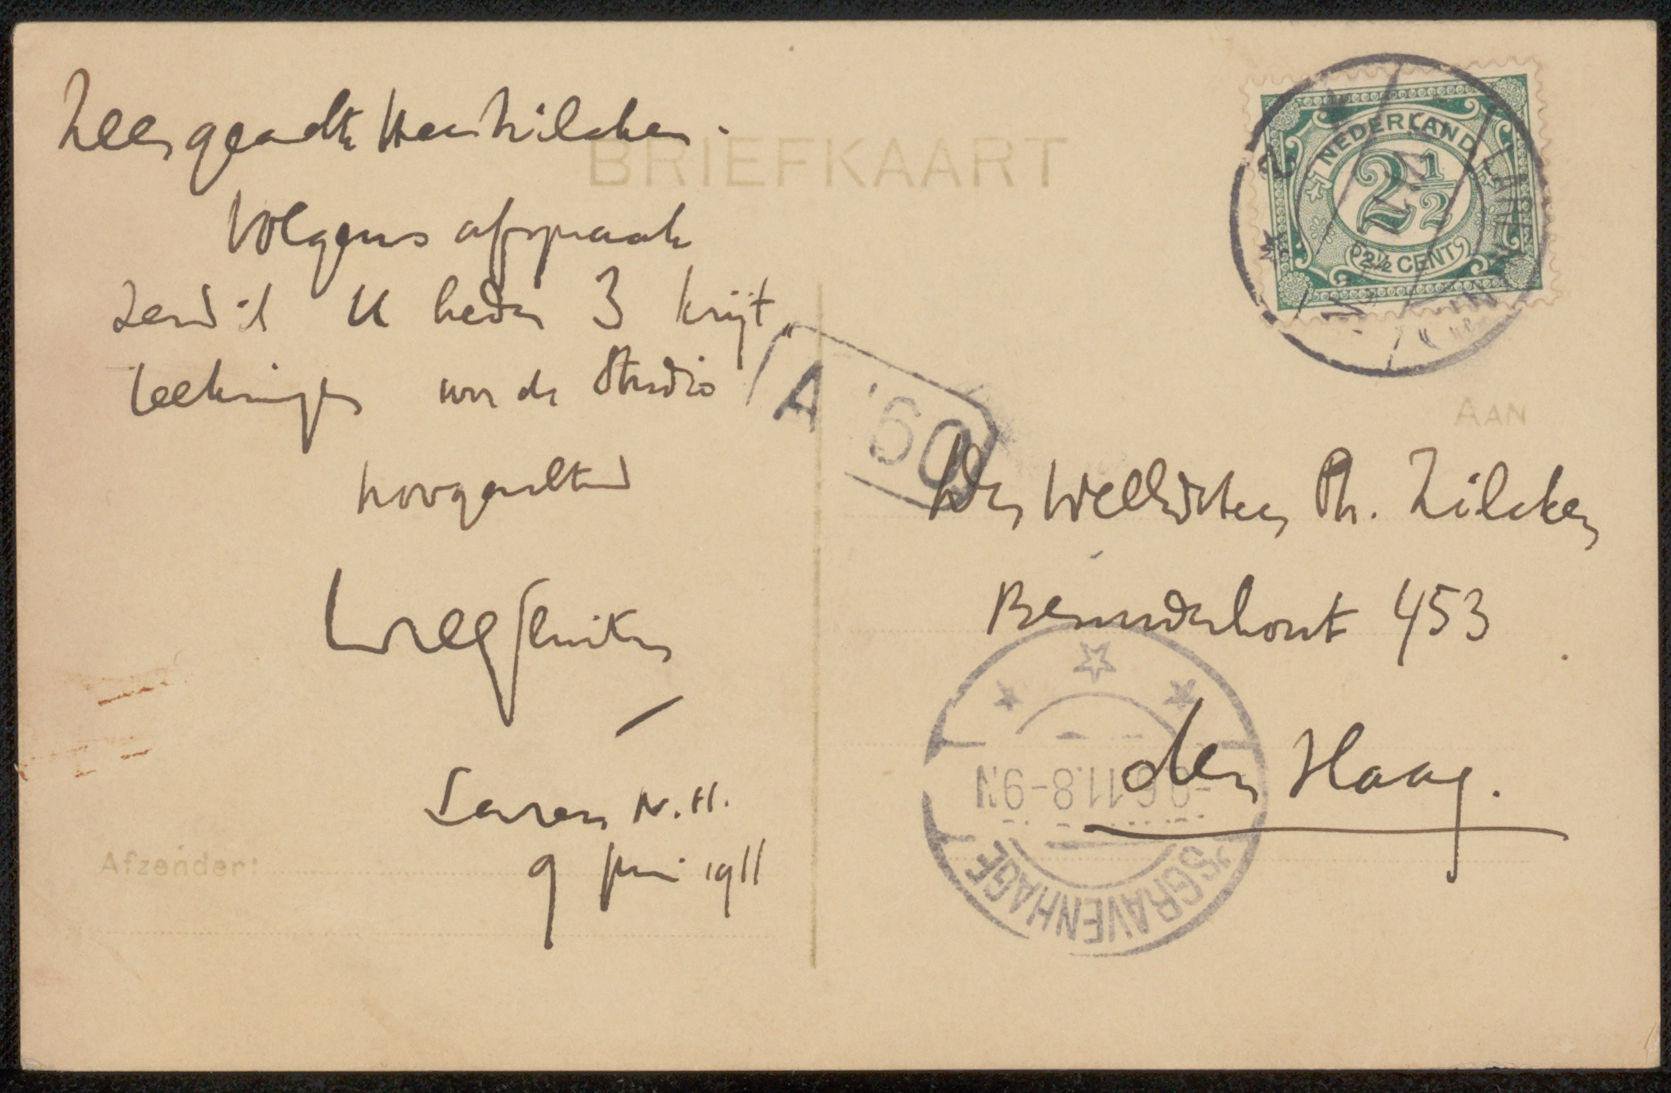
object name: postcard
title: Briefkaart aan Philip Zilcken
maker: willy sluiter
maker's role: draughtsman, painter, print maker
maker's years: 1873-1949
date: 1911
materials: cardboard, ink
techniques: pen, writing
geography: laren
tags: the hague, draughtsman, philip zilcken, drawing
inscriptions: collector's mark: ‘RPK’